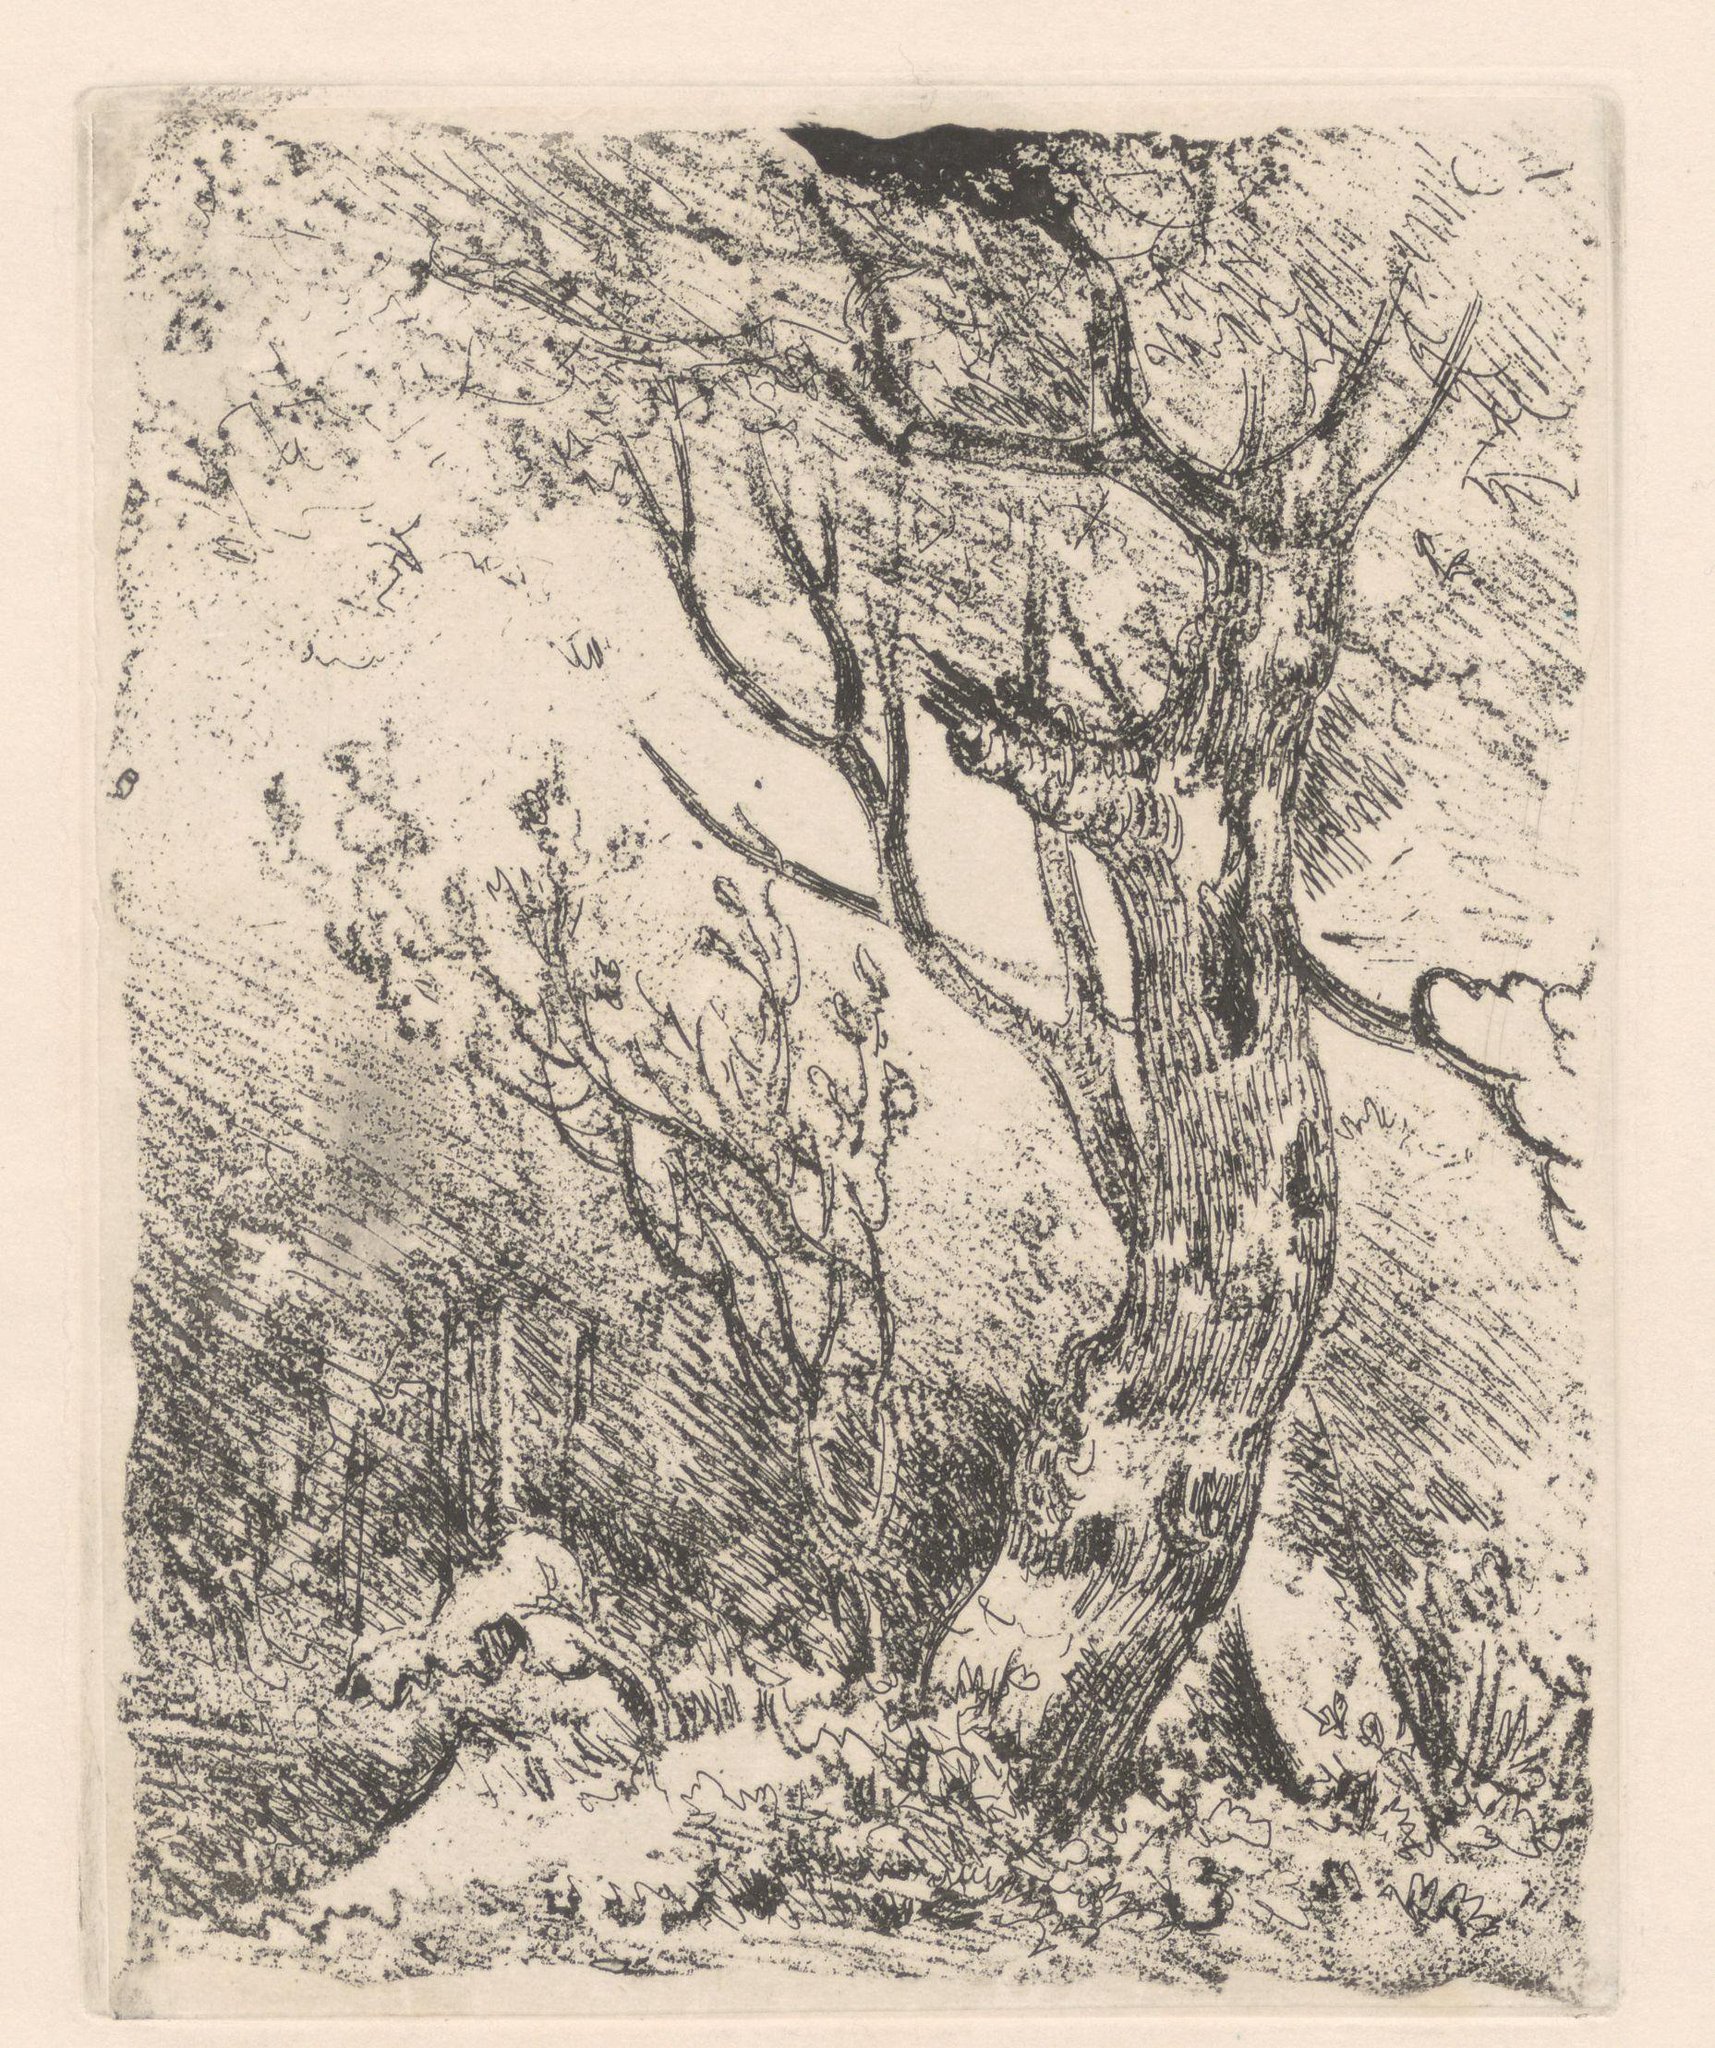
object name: print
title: Boom met kale takken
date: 1834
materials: paper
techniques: drypoint, soft ground etching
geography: norwich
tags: trees, shrubs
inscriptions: collector's mark: Lugt 2228, collector's mark: Lugt 2760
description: Prent staat samen met RP-P-1973-197 op een onversneden blad.